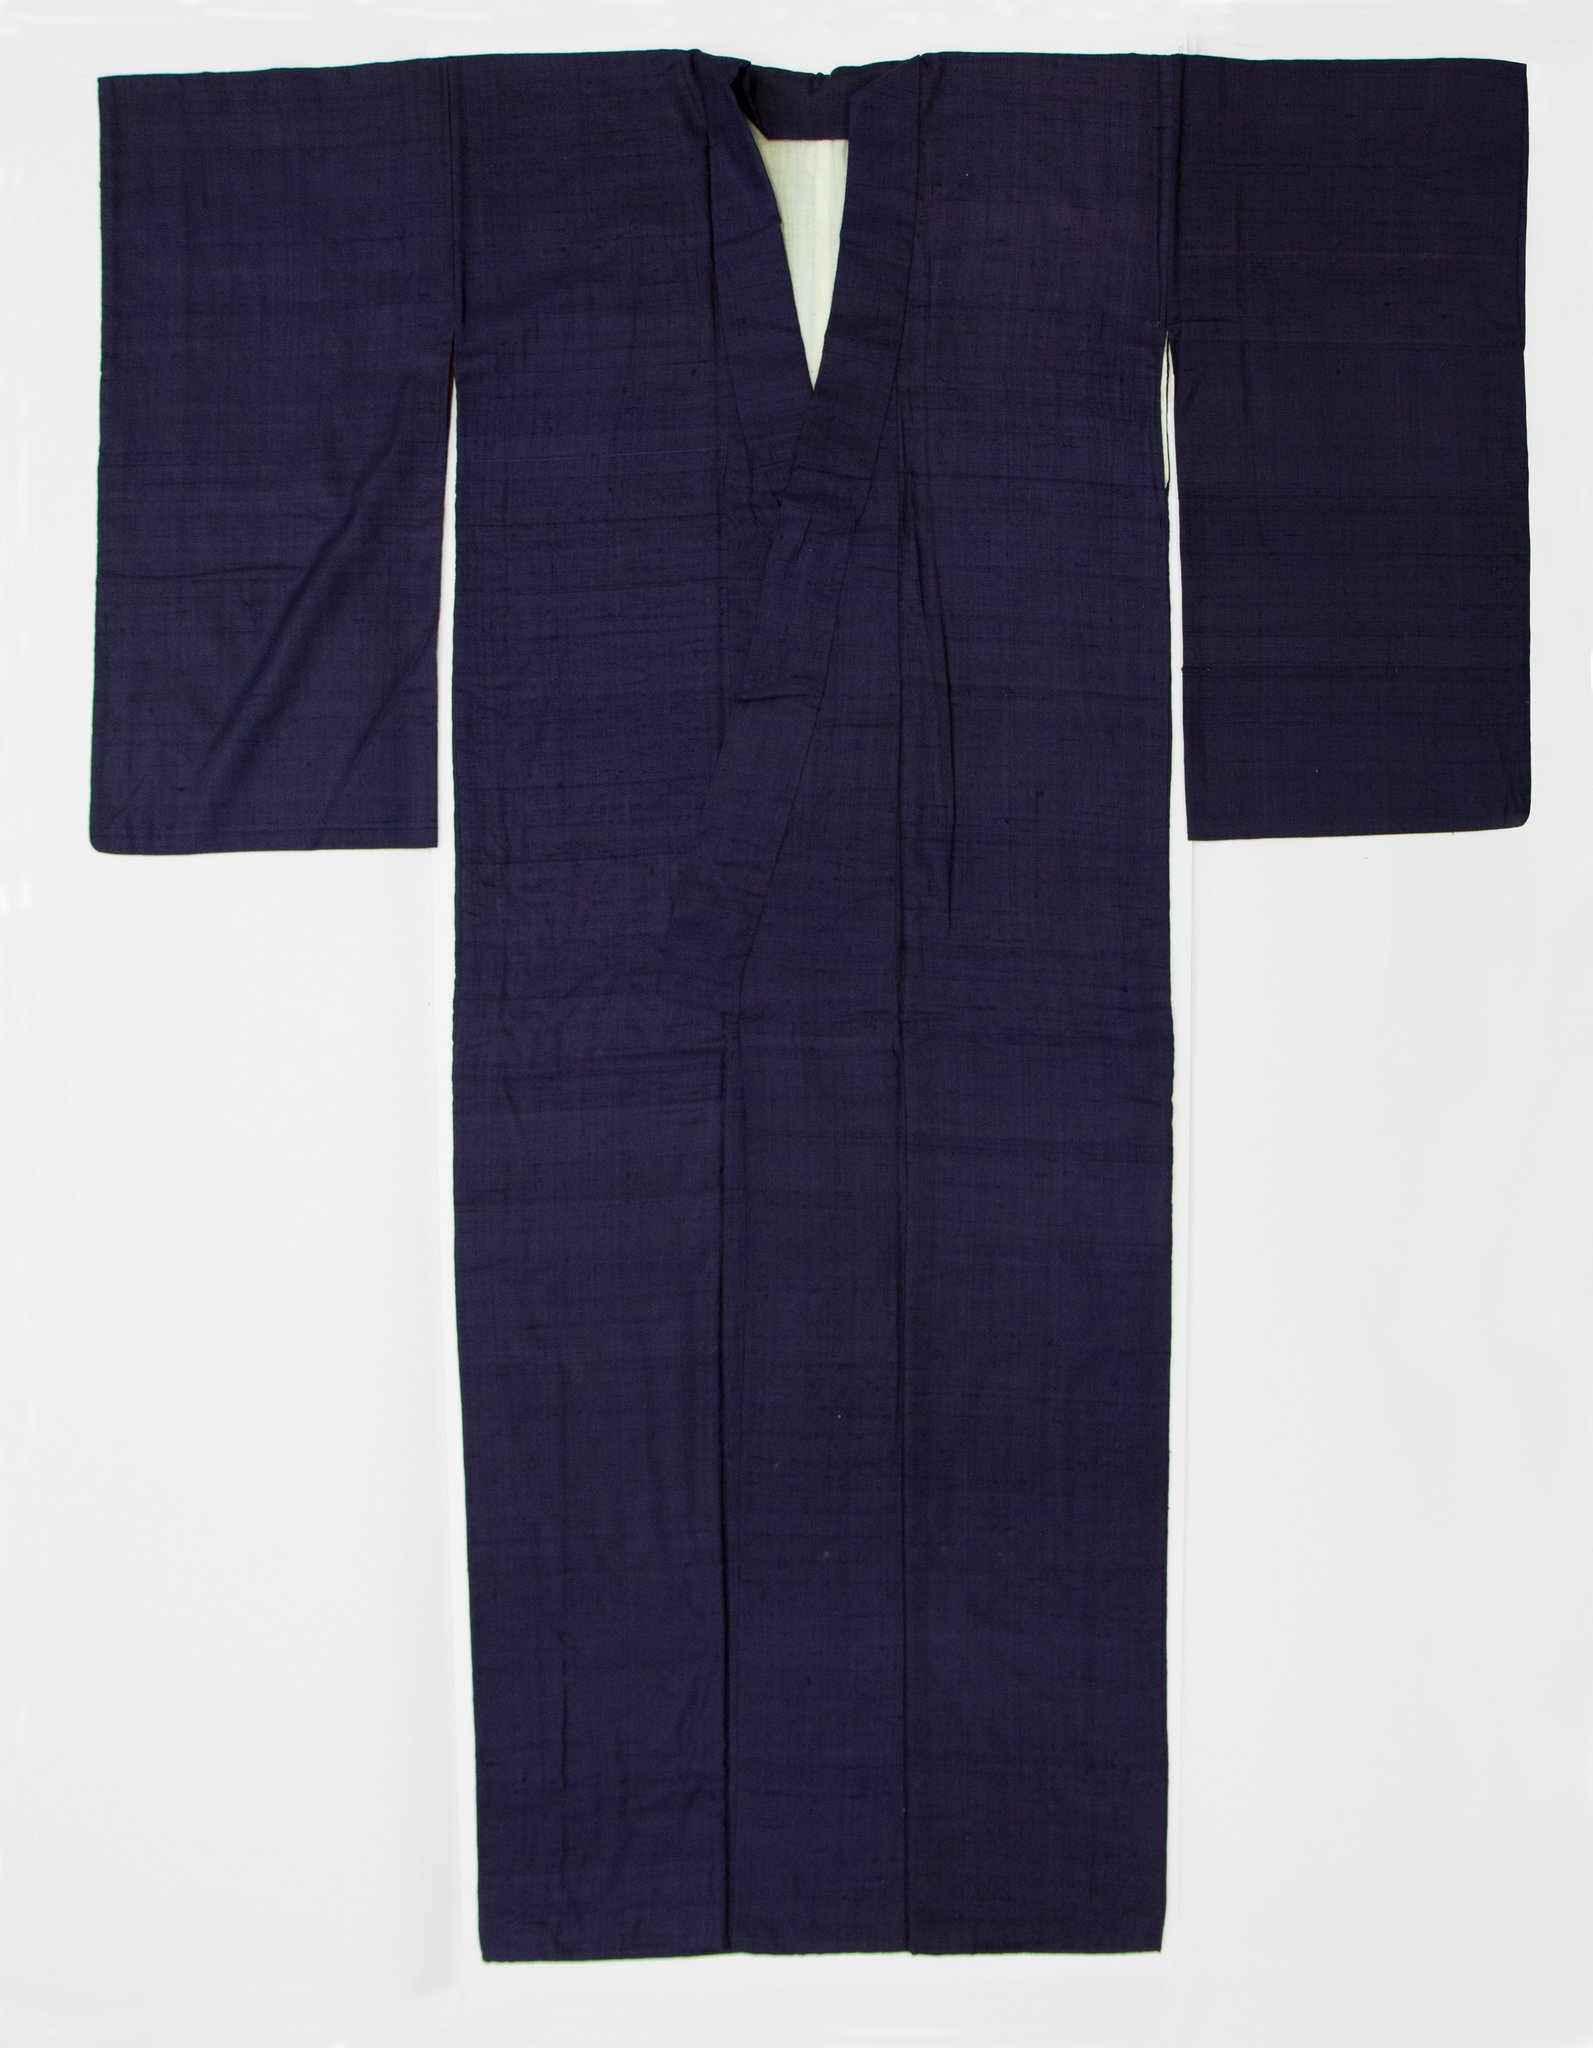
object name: kosode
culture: japanese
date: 1615-1868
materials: silk